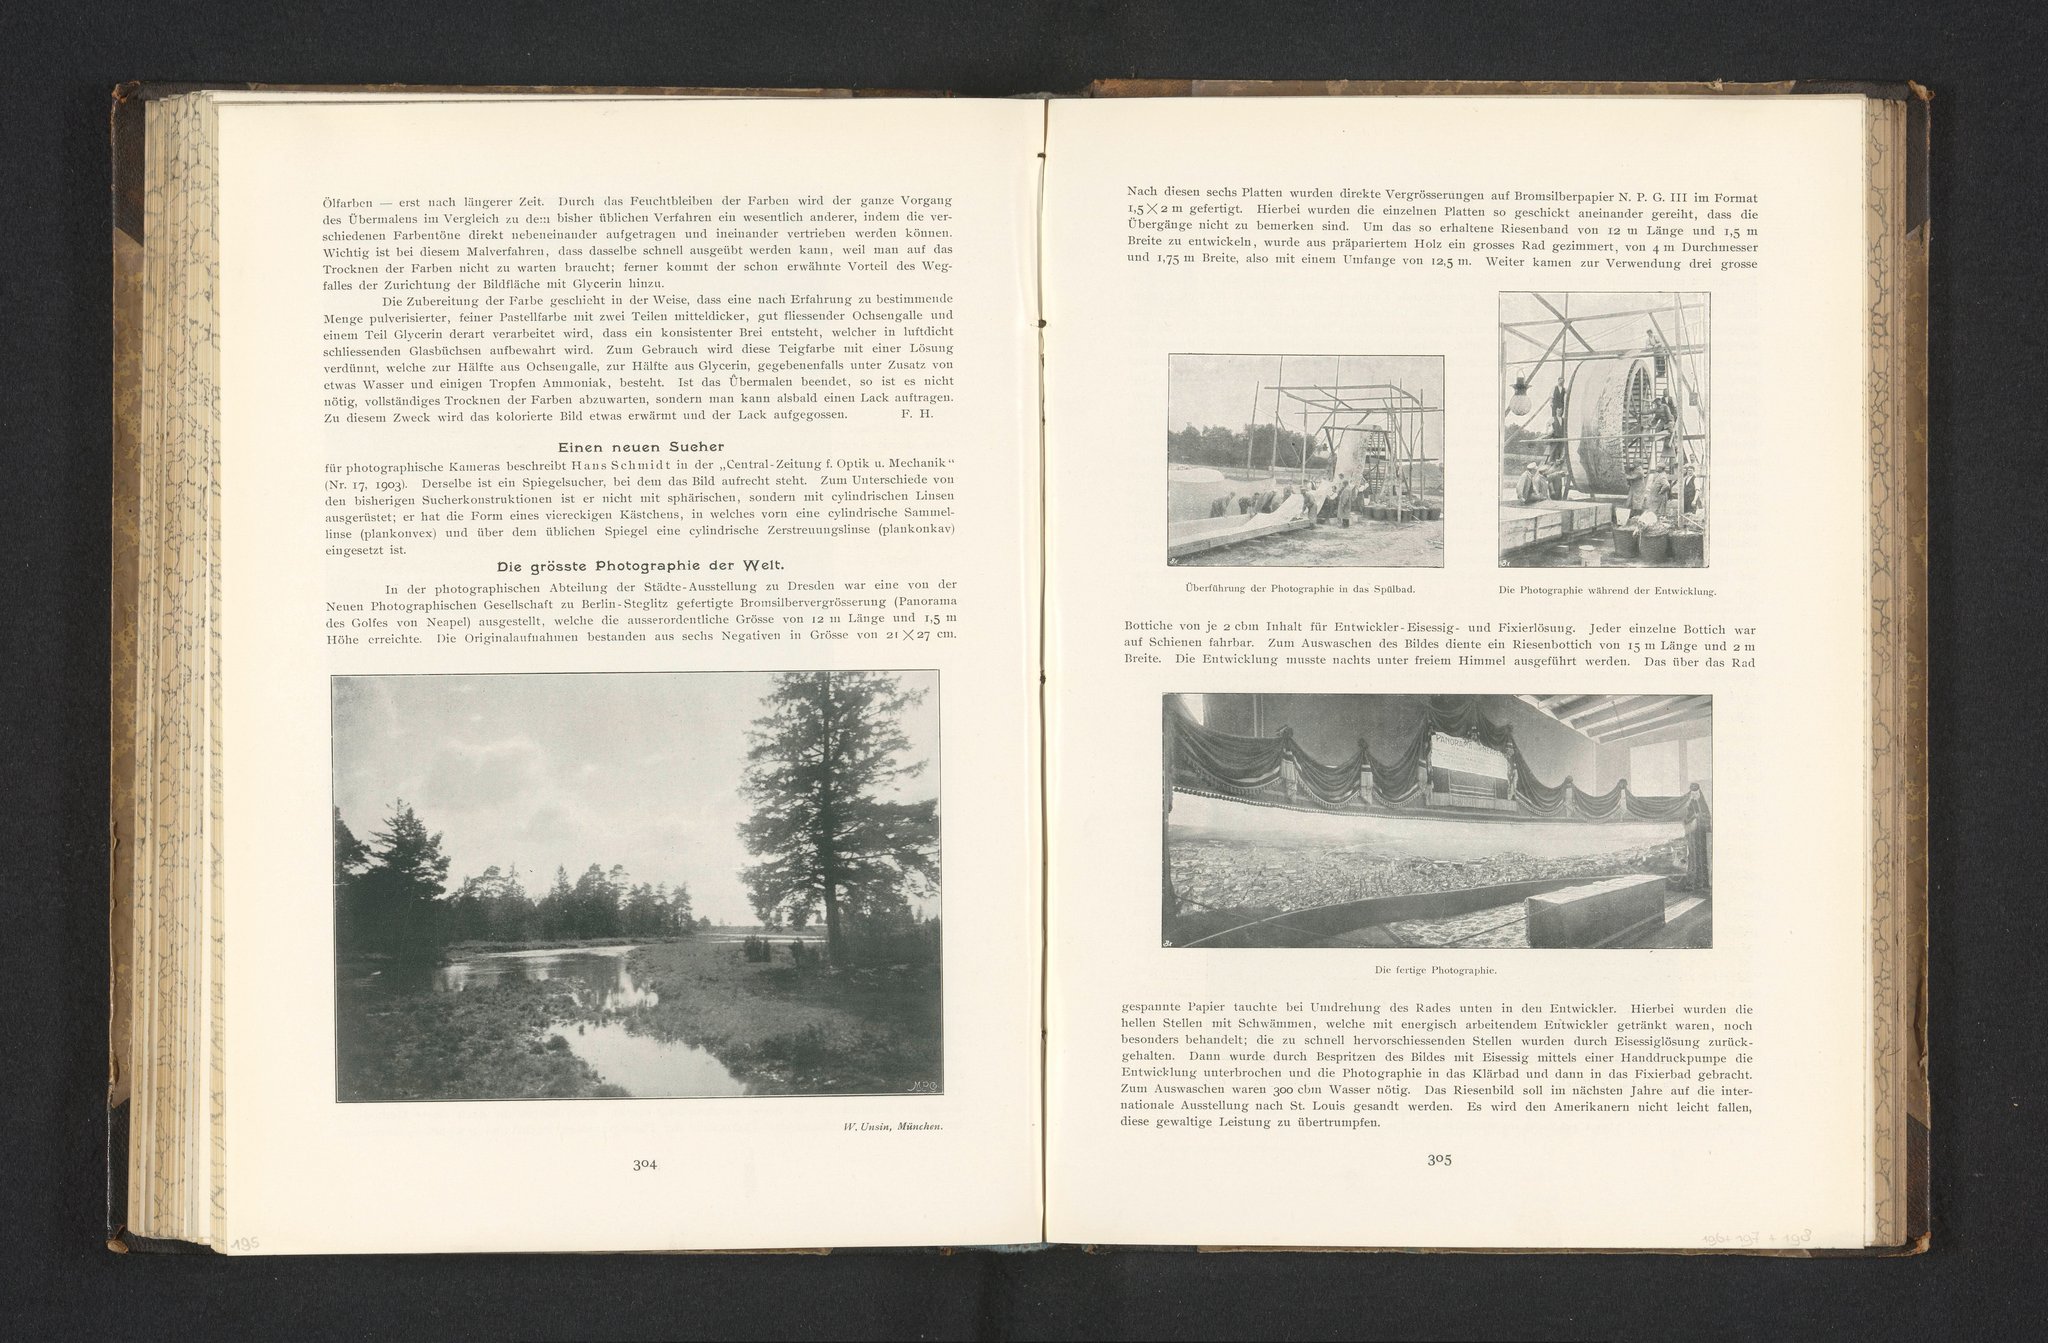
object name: photomechanical print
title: Gezicht op een panoramafoto van Napels van 1,5 bij 12 meter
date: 1898-1903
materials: paper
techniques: autotype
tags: panorama, cyclorama, photograph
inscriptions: monogram: ‘BX’